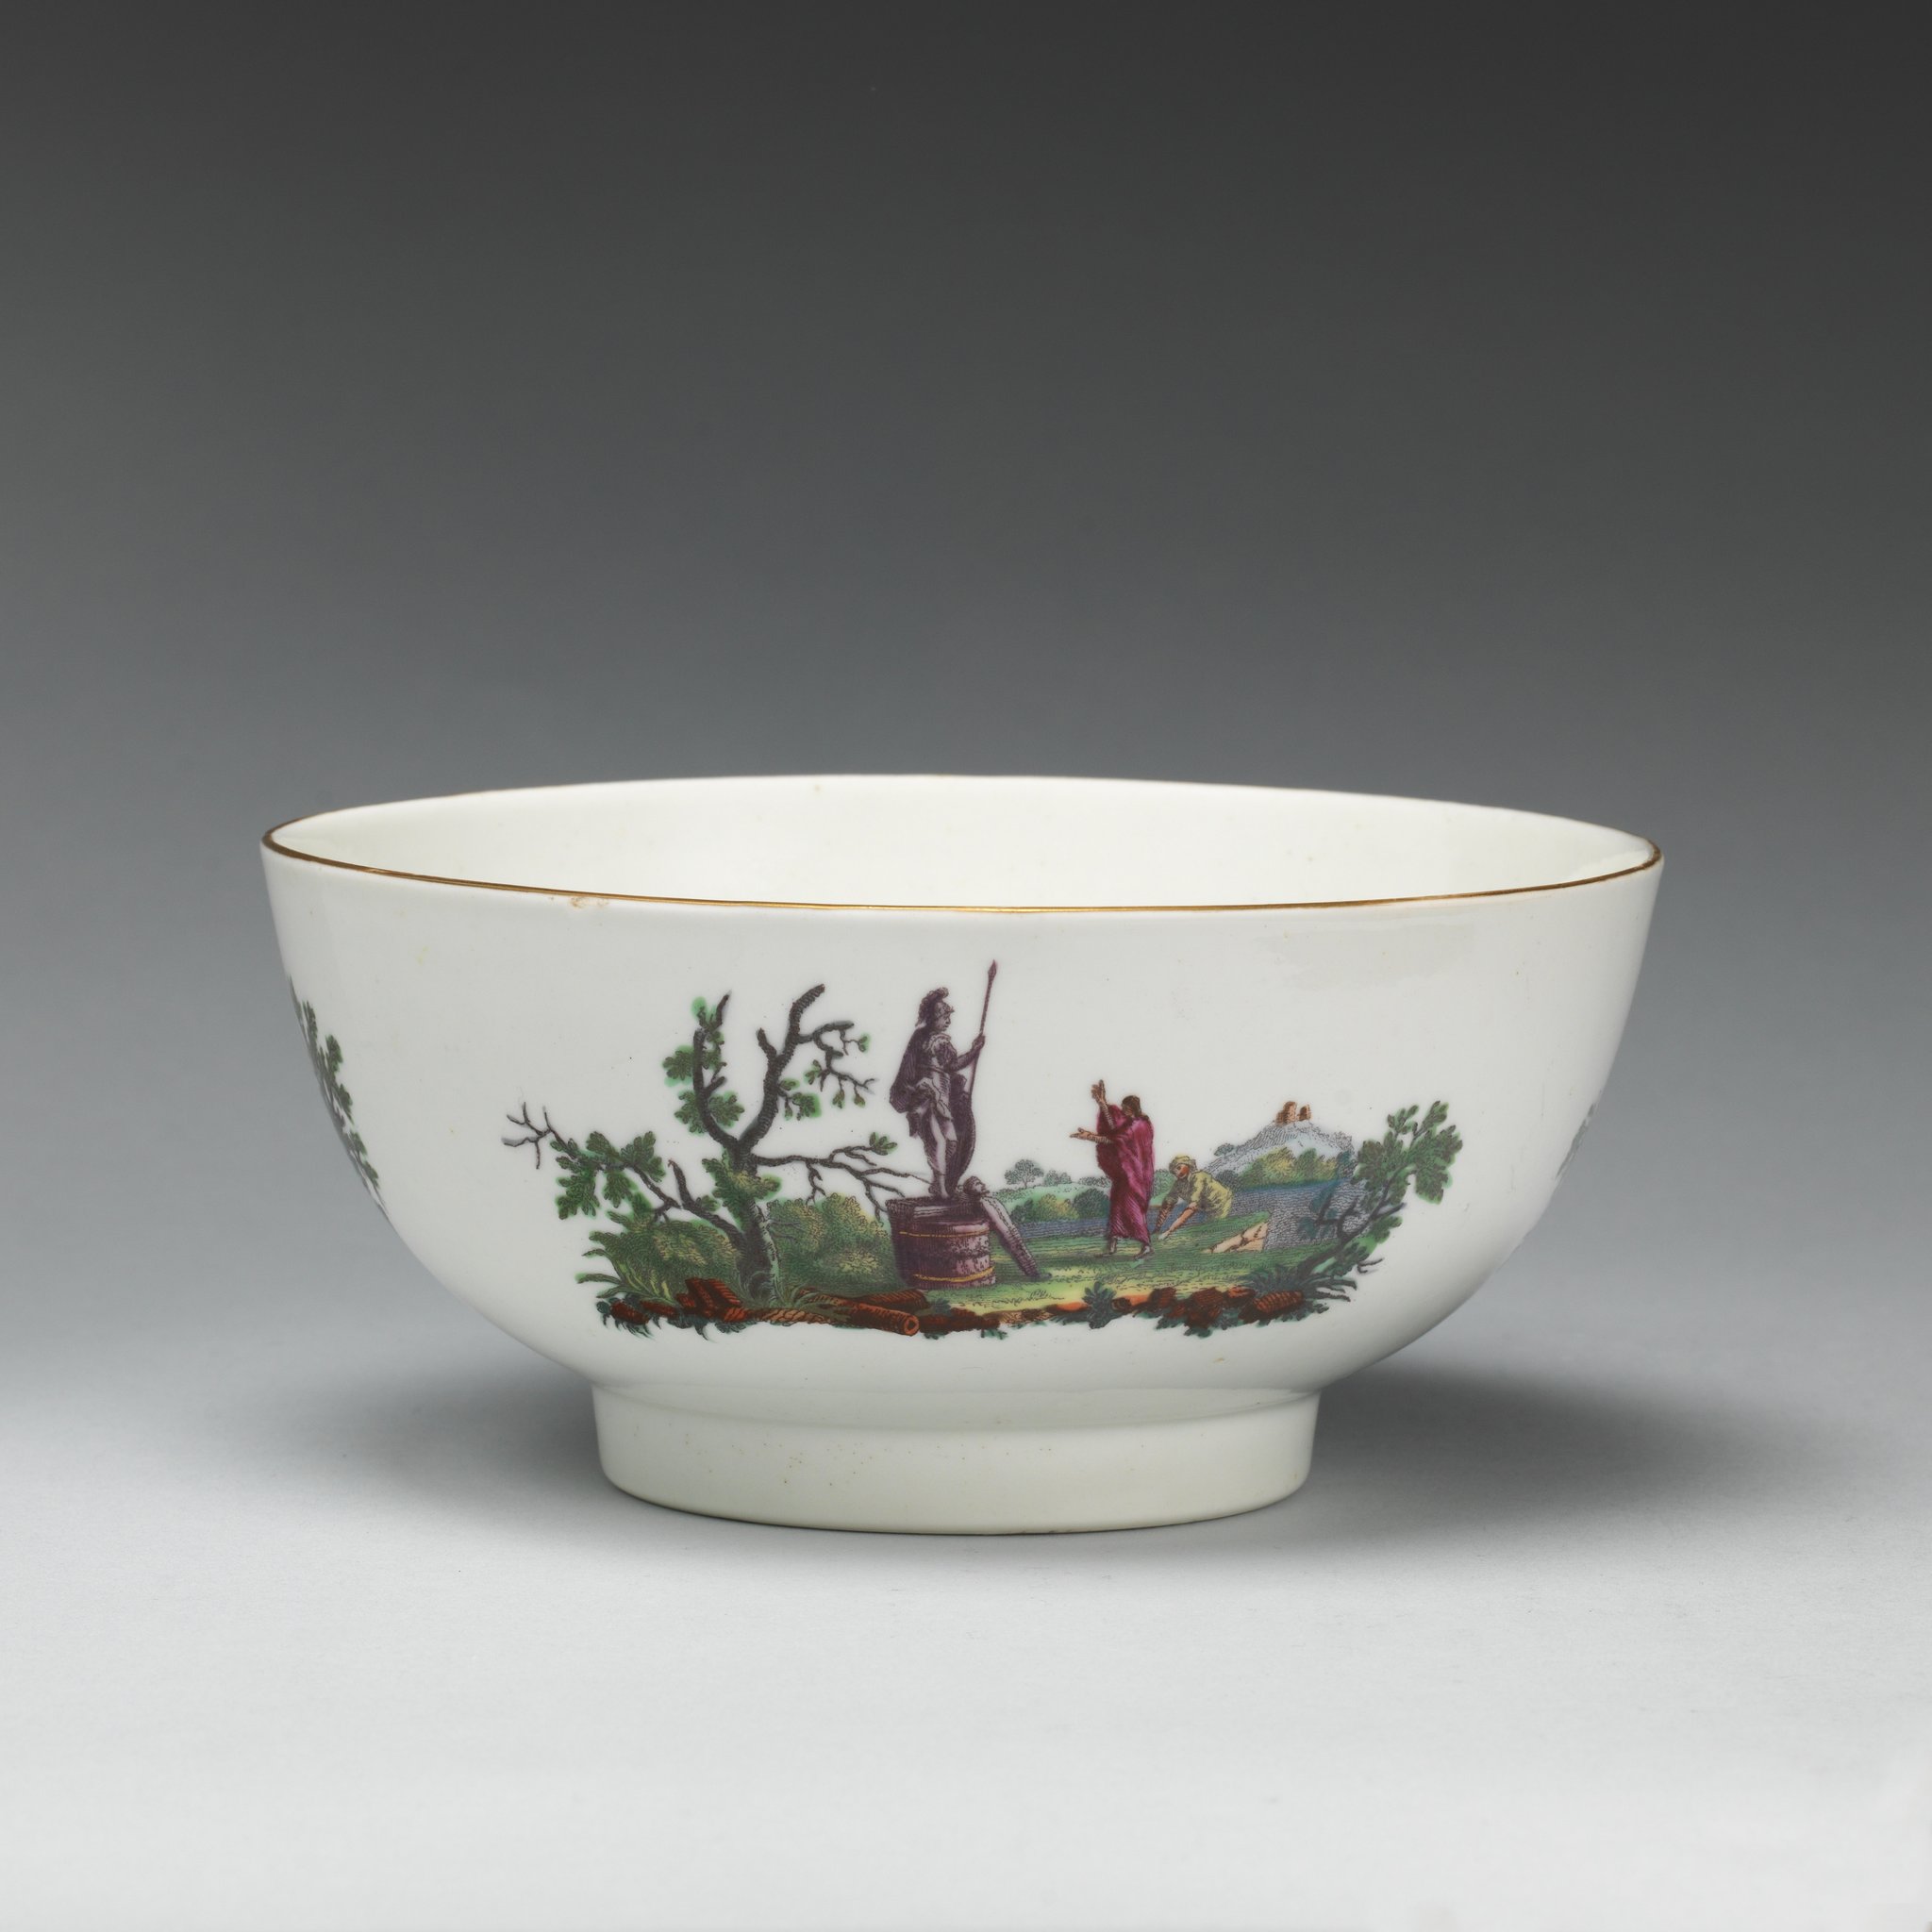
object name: bowl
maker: worcester factory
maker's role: factory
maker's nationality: british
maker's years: 1751-2008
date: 1770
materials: soft paste porcelain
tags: human figures,landscapes